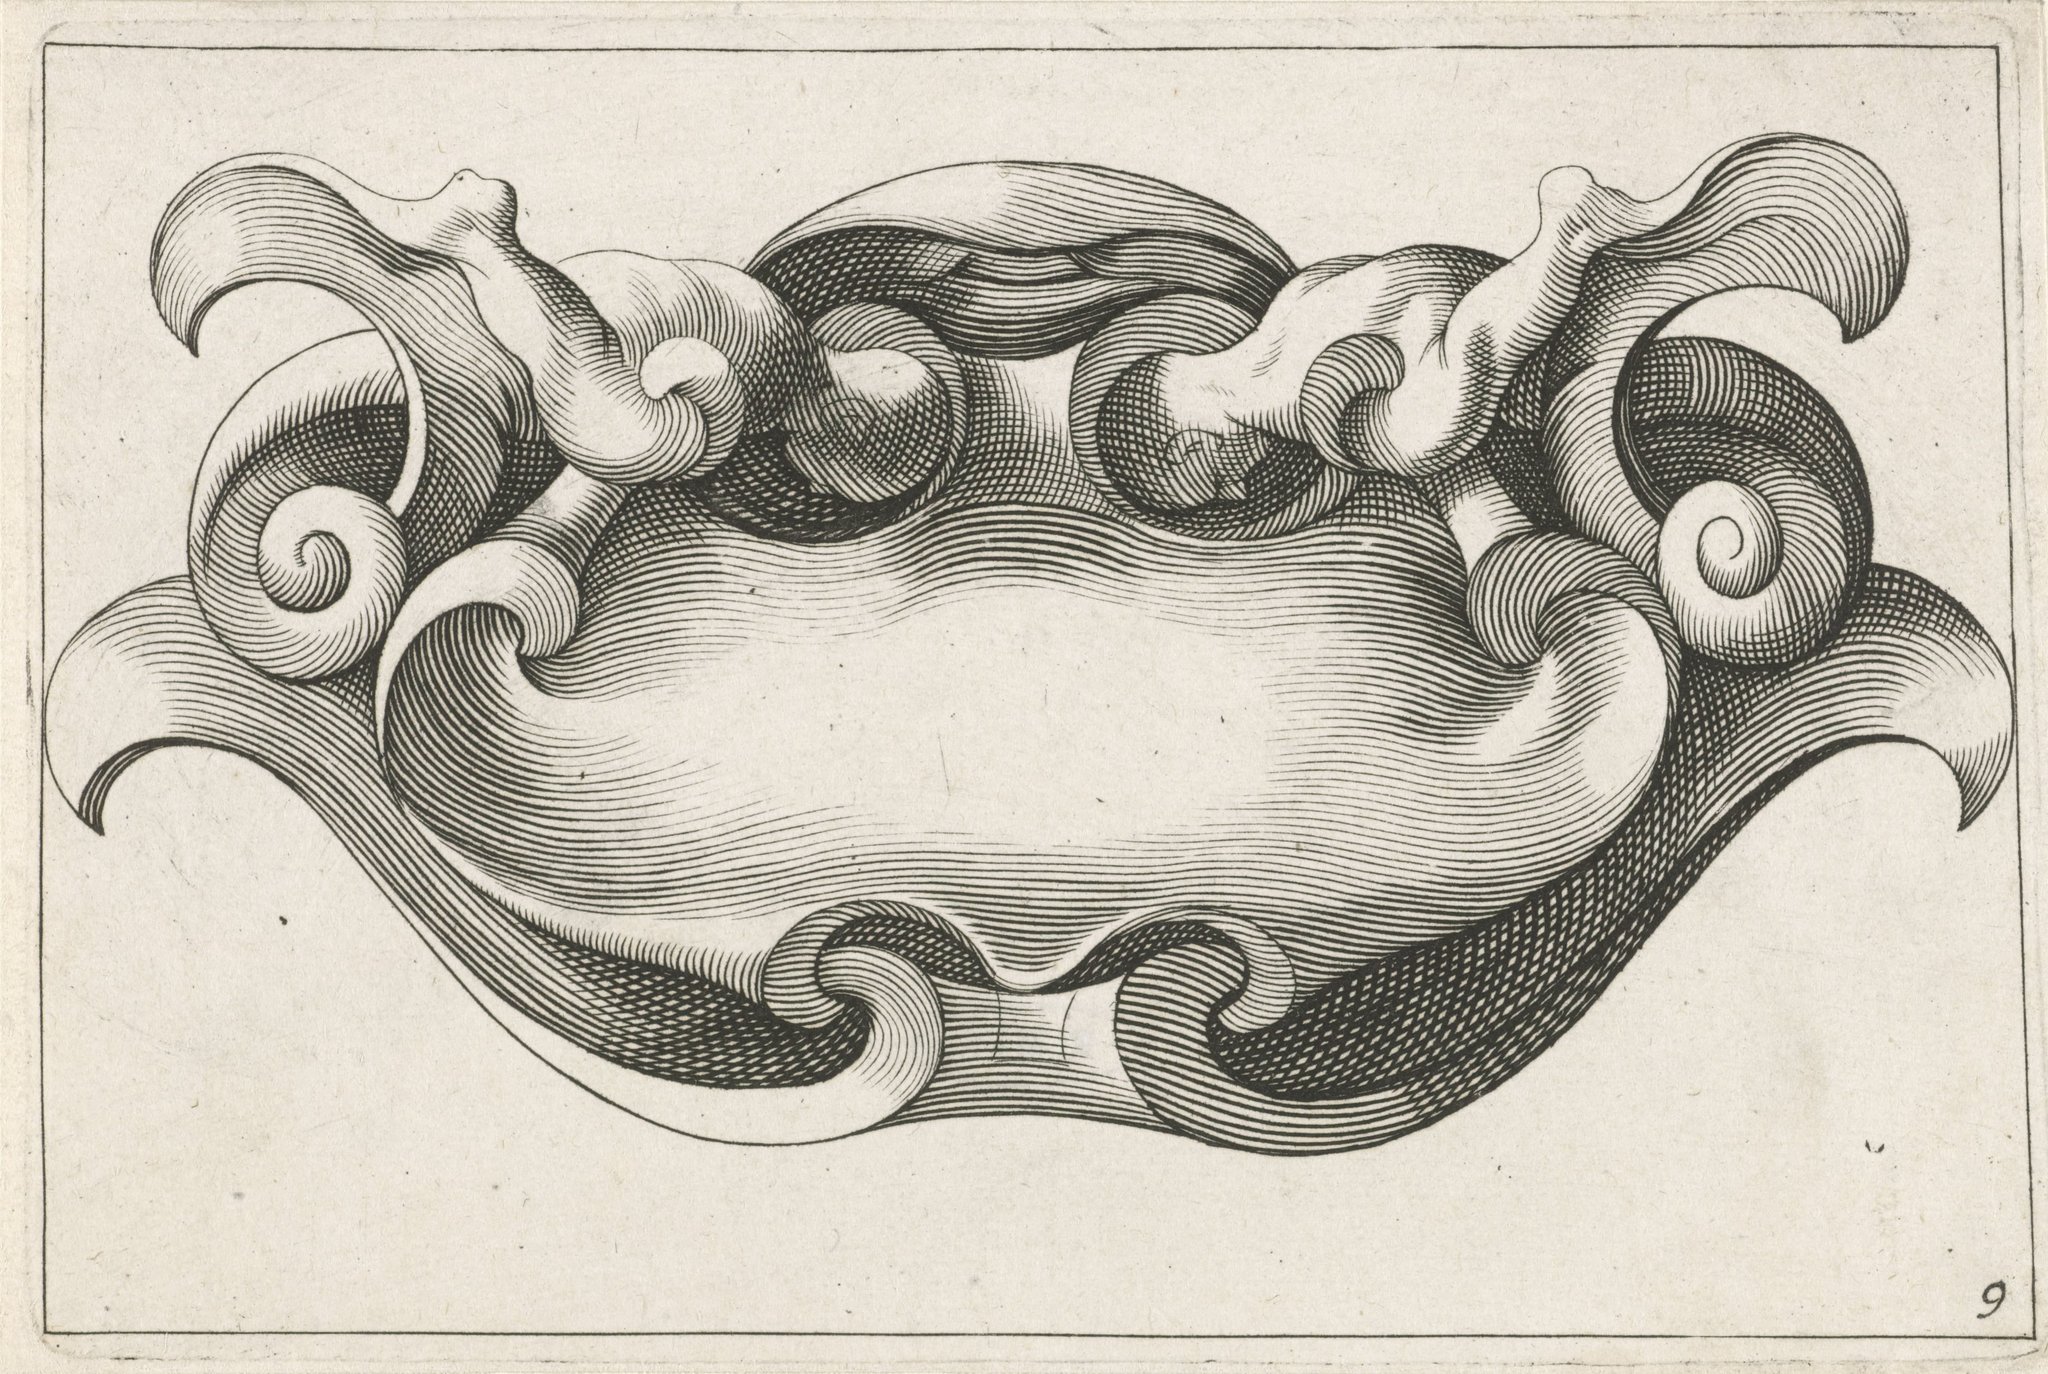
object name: ornament print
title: Differents Conpartimens et Chapiteaux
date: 1657-1685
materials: paper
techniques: engraving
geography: paris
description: Uit serie van 22 of 29 bladen met cartouches in Italiaanse kwabstijl, vierde editie.